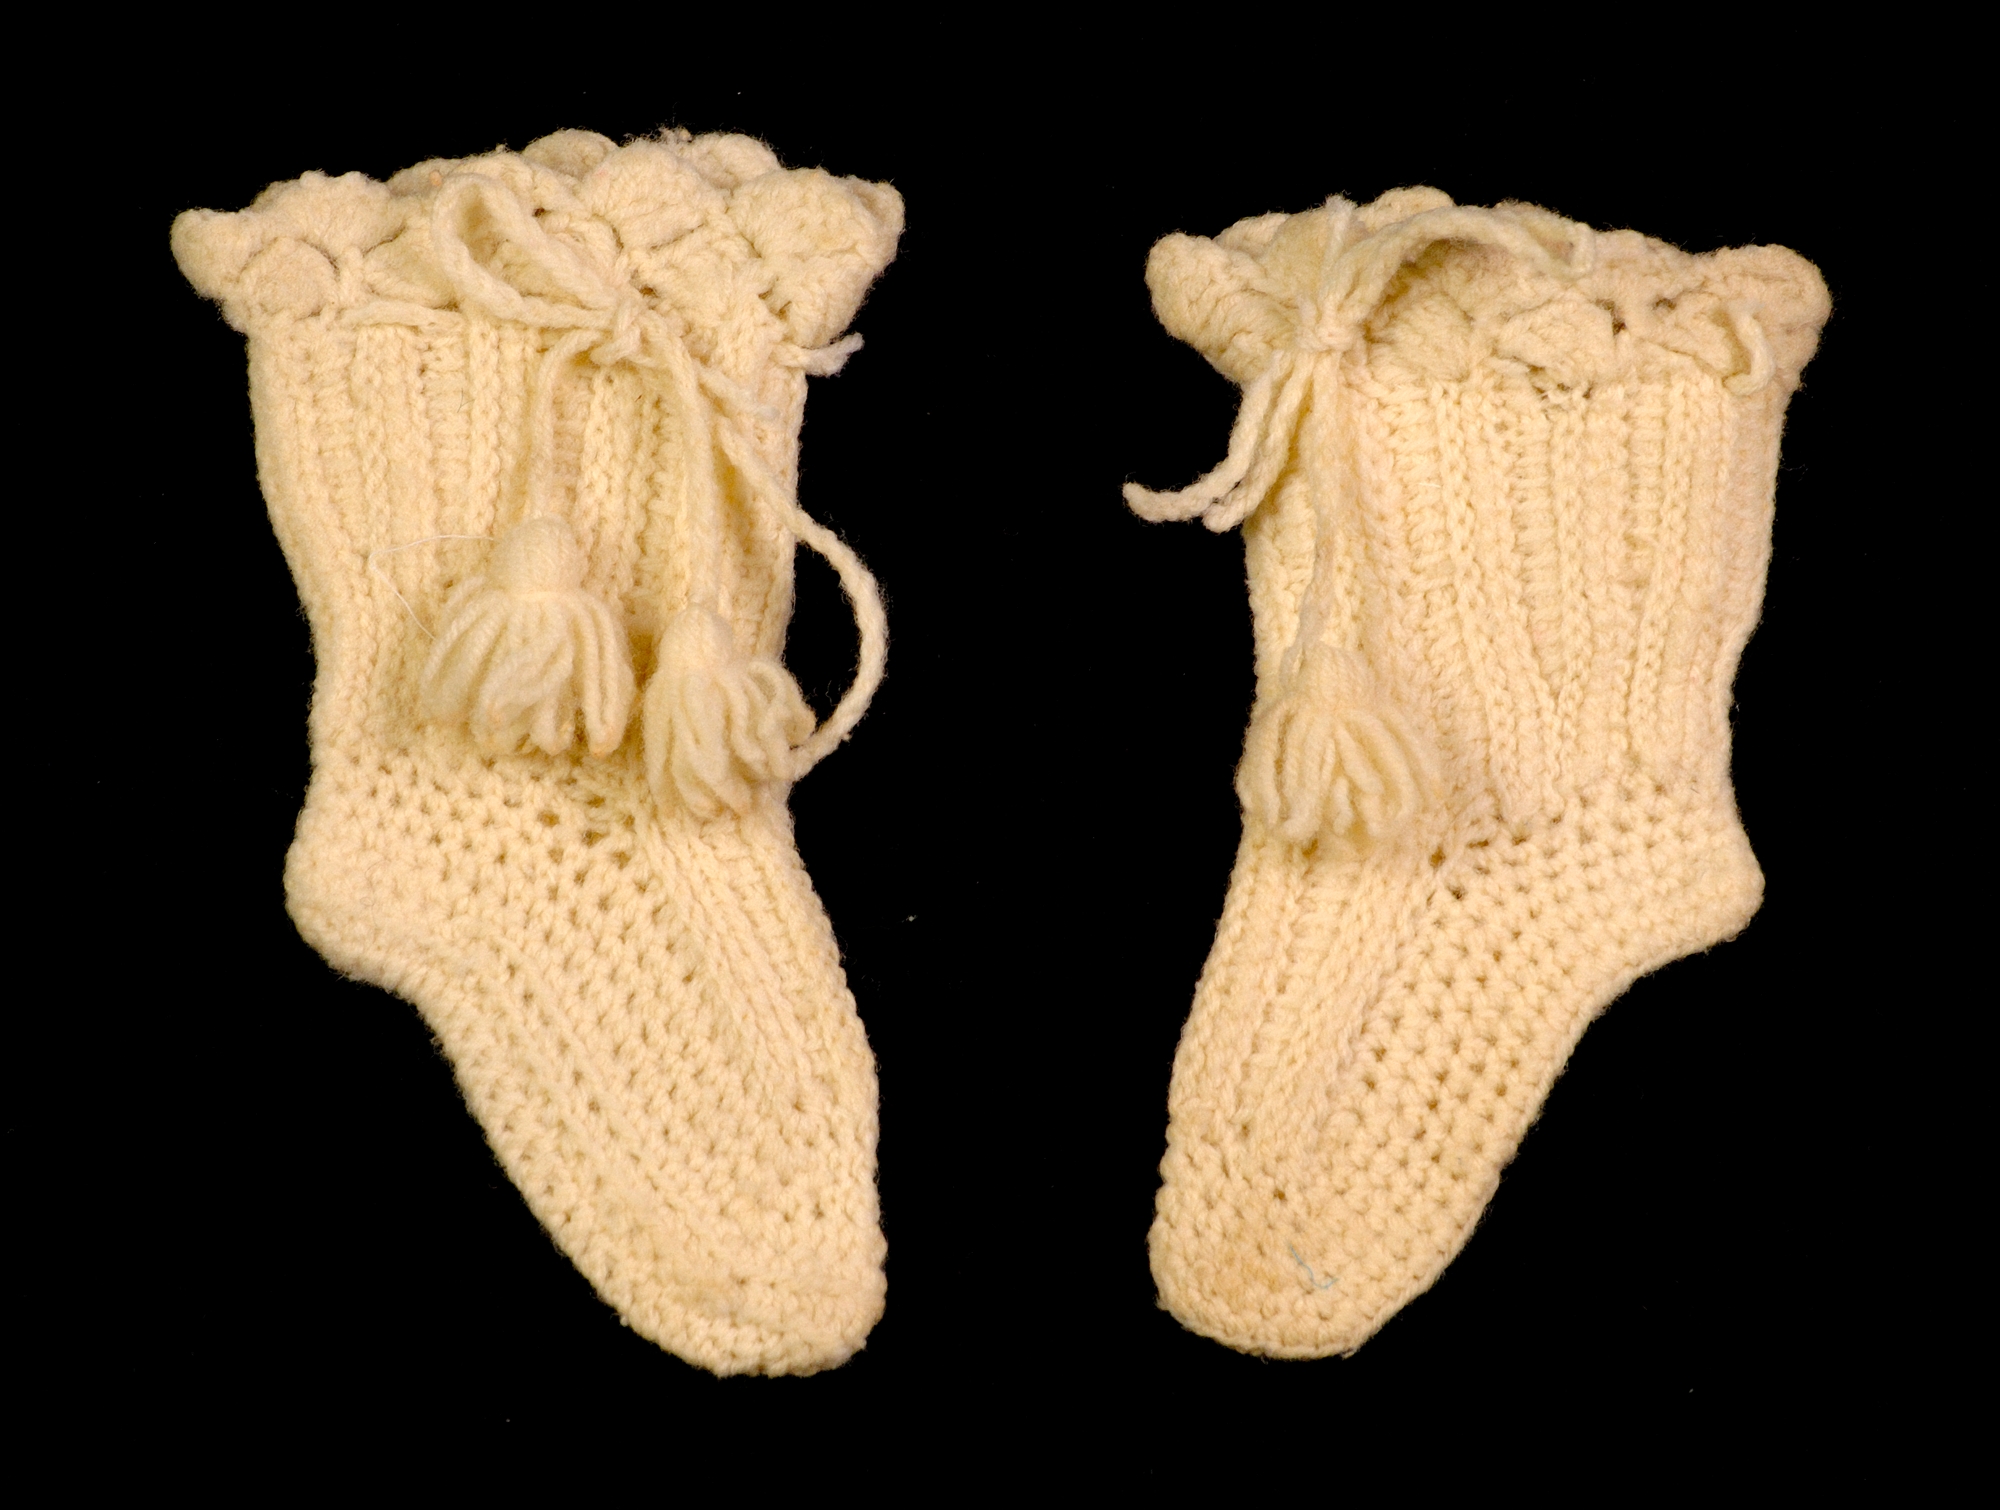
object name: bootee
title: Bootees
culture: american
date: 1870-1880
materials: wool